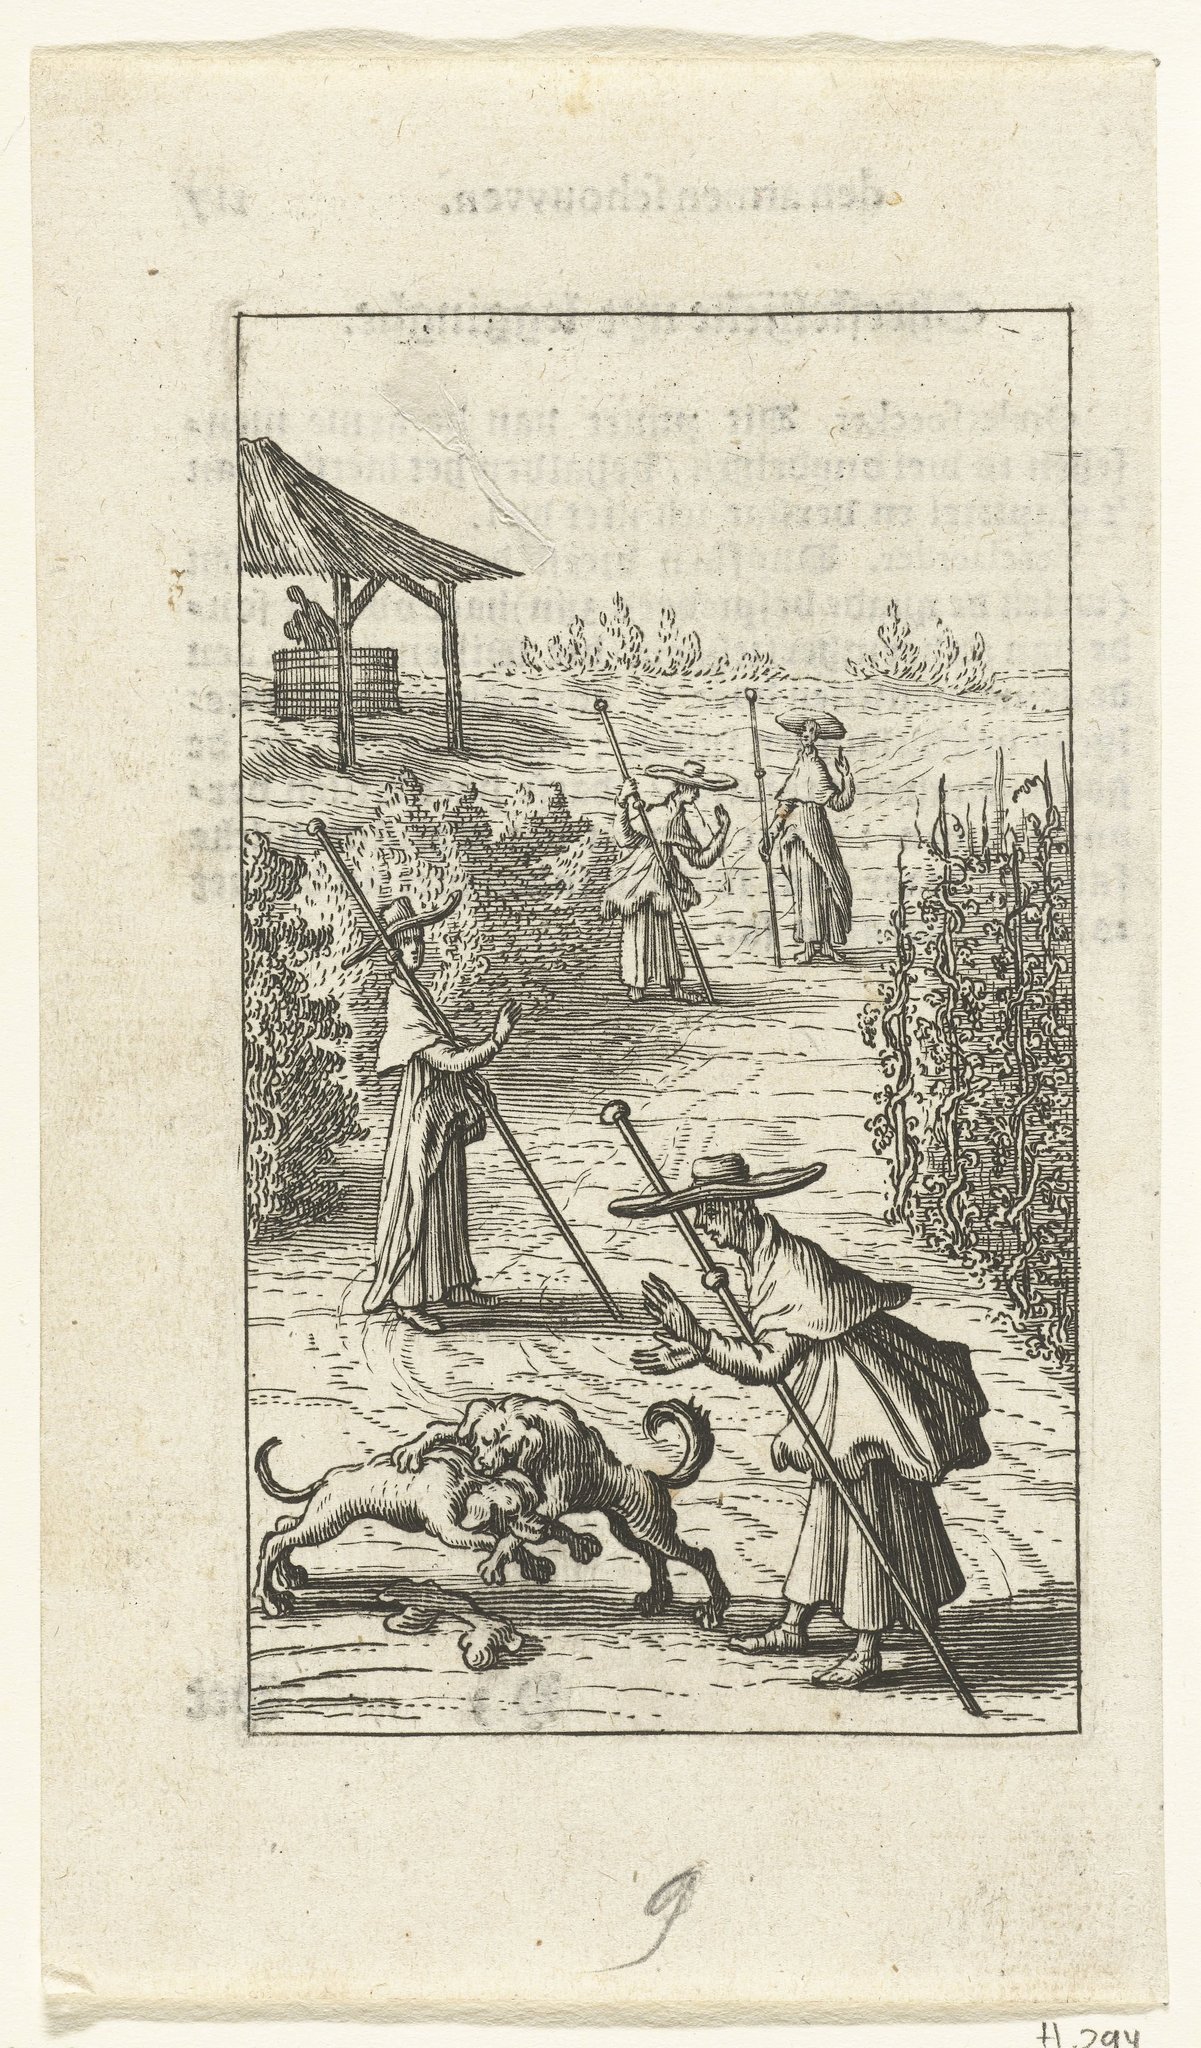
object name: book illustration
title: Willemynken moedigt vechtende honden aan en Dyfken vermaant haar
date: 1590-1627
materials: paper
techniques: engraving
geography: antwerp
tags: pilgrim(s), animals (+ fighting animals; aggressive relations), dog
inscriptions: collector's mark: Lugt 2228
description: Prent uit: Boëtius Adamsz. Bolswert, Duyfkens en Willemynkens pelgrimagie tot haren beminden binnen Iervsalem. Haerlieder teghenspoet, belet en eynde, Antwerpen, Hendrick Aertssens, 1638. Op het verso staat een verklarende Nederlandse tekst bij de voorgaande illustratie in dit devotie boekje (vergelijk RP-P-BI-2197).